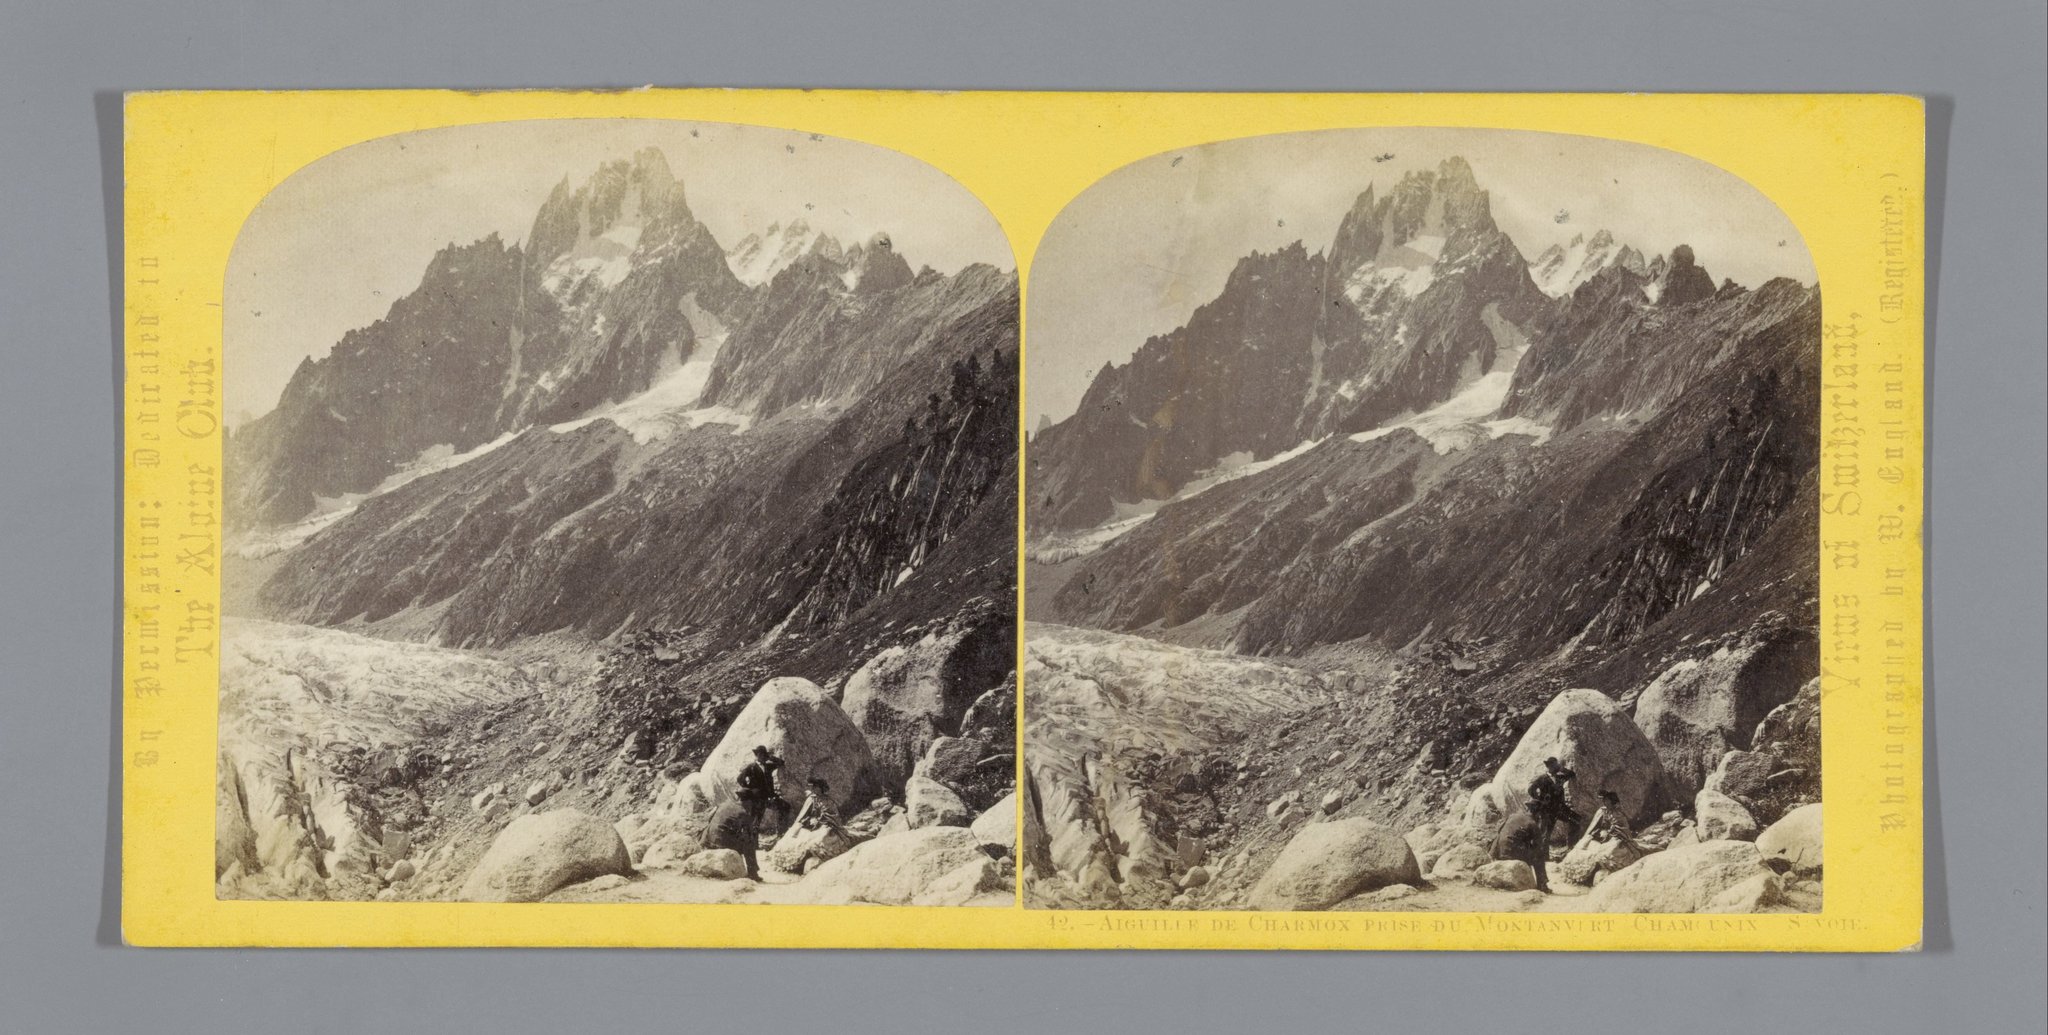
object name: stereograph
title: Aiguille de Charmox prise du Montanvert Chamounix. Savoie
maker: william england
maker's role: fotograaf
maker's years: 1816-1896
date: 1850-1880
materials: cardboard, photographic support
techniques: albumen print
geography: haute-savoie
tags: mountain-top, peak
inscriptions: number: ‘42.’, inscription: ‘Views of Switzerland, photographed by W. England. (Registered) Under the Special Patronage of the Alpine Club.’